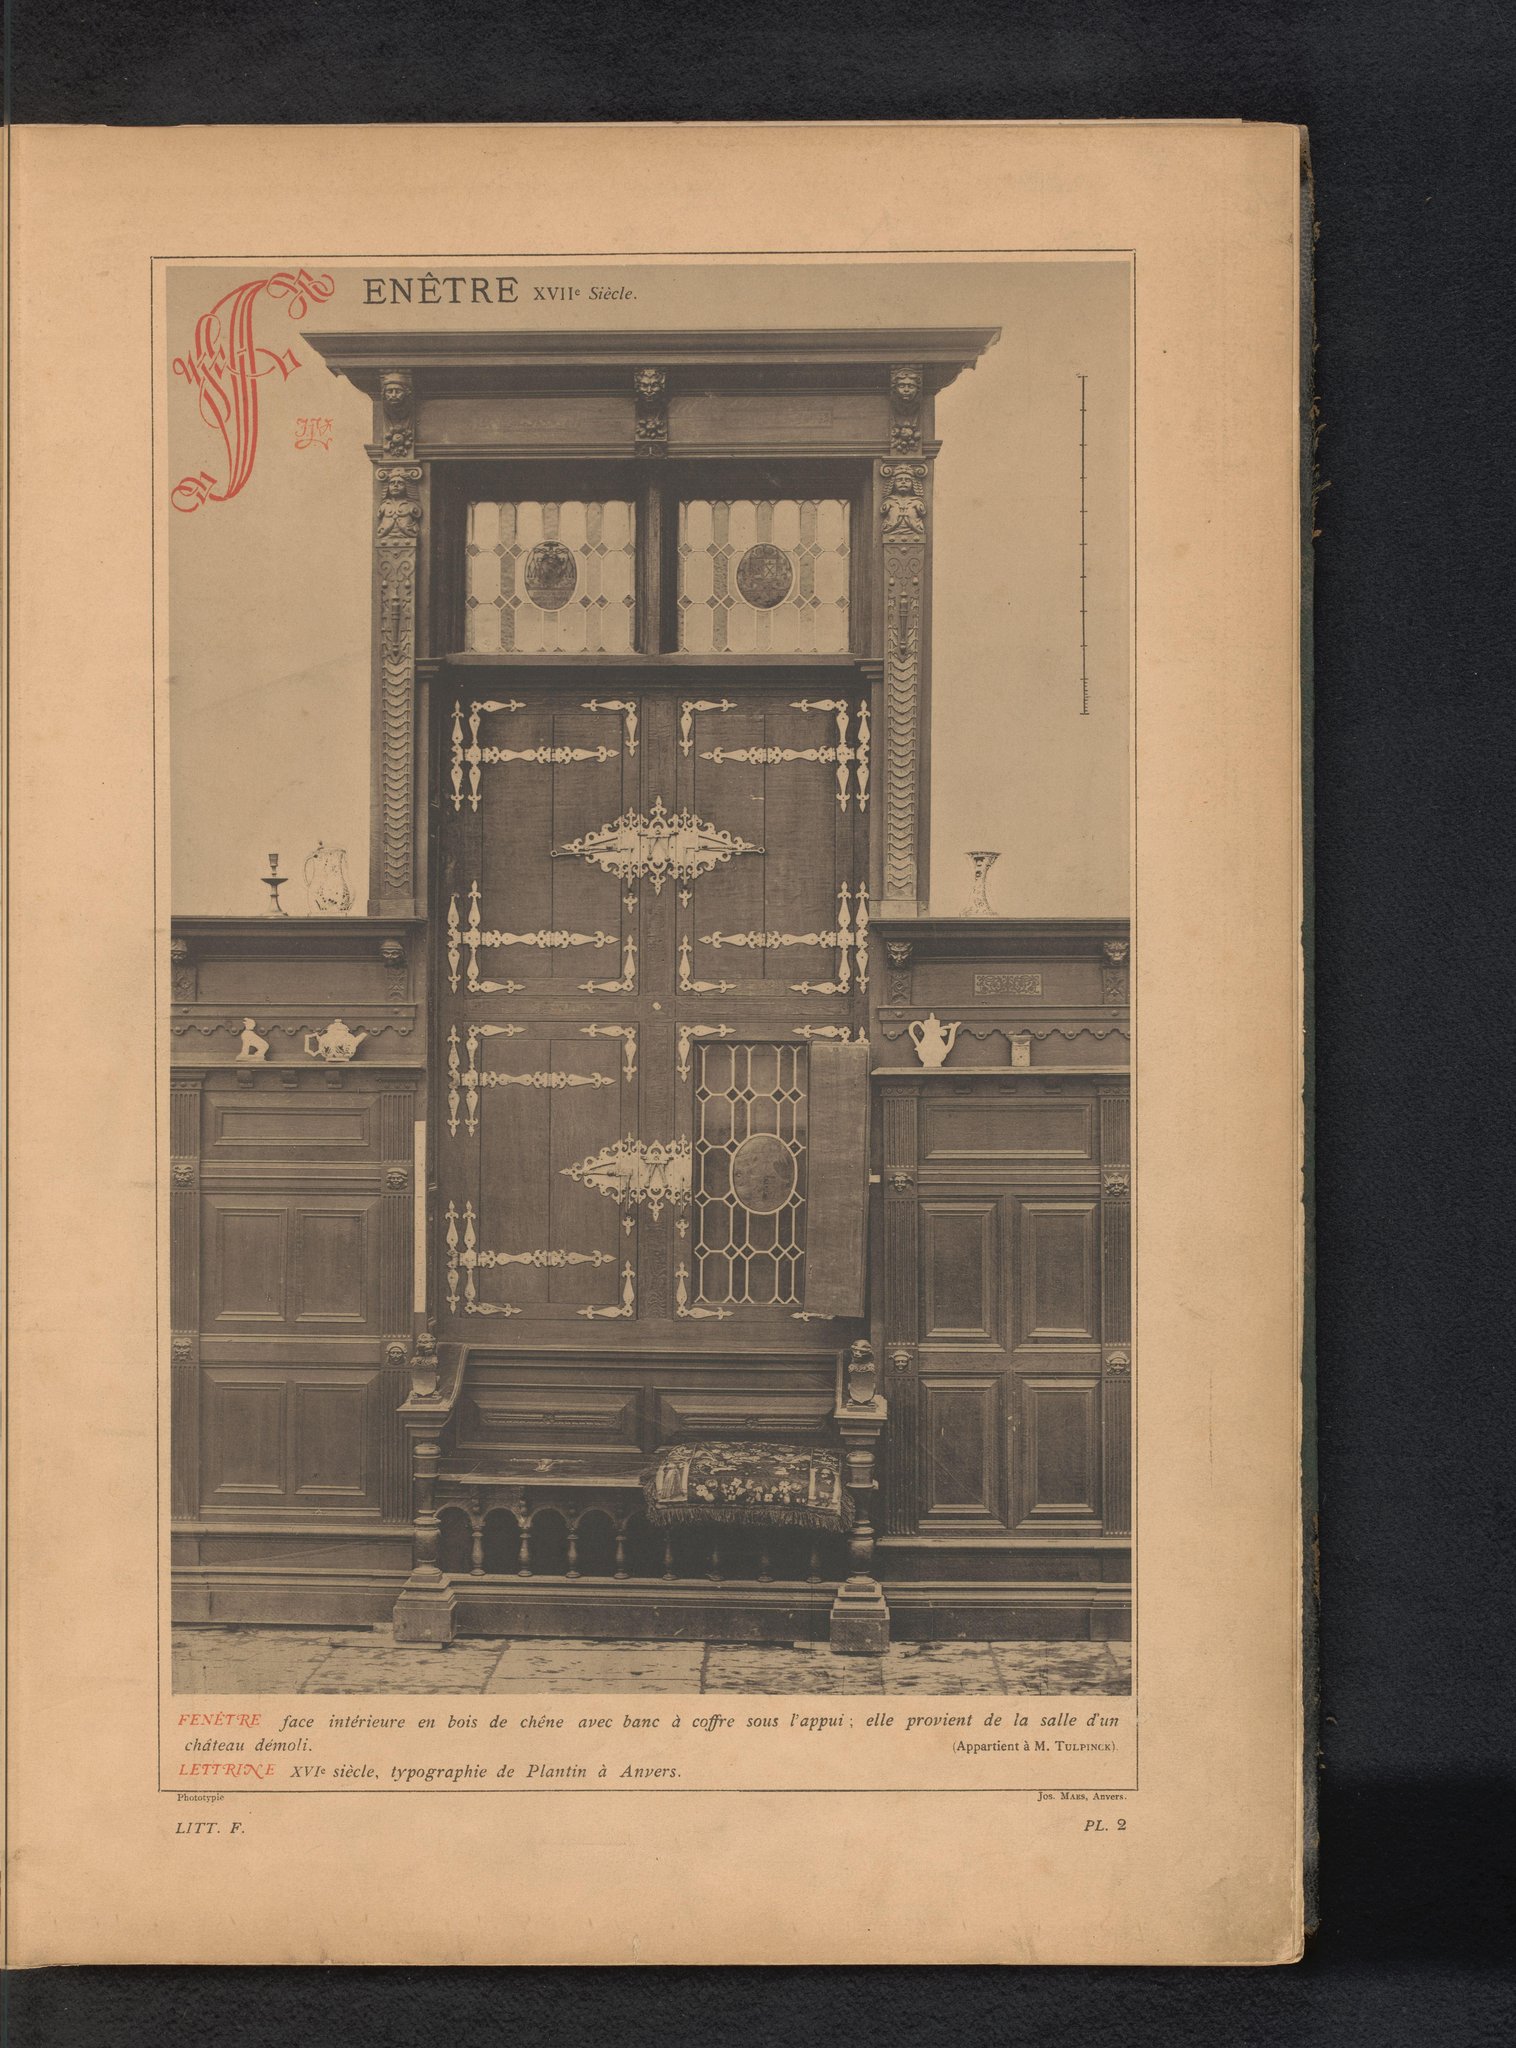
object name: page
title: Raam met eikenhouten luiken en bank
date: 1875-1880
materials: paper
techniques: photograph, photolithography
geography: antwerp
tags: window-seat, window shutters on the inside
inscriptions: monogram: ‘JJvY’, inscription: ‘FENÊTRE face intérieure (...)’, inscription: ‘LITT. F. - PL. 2’